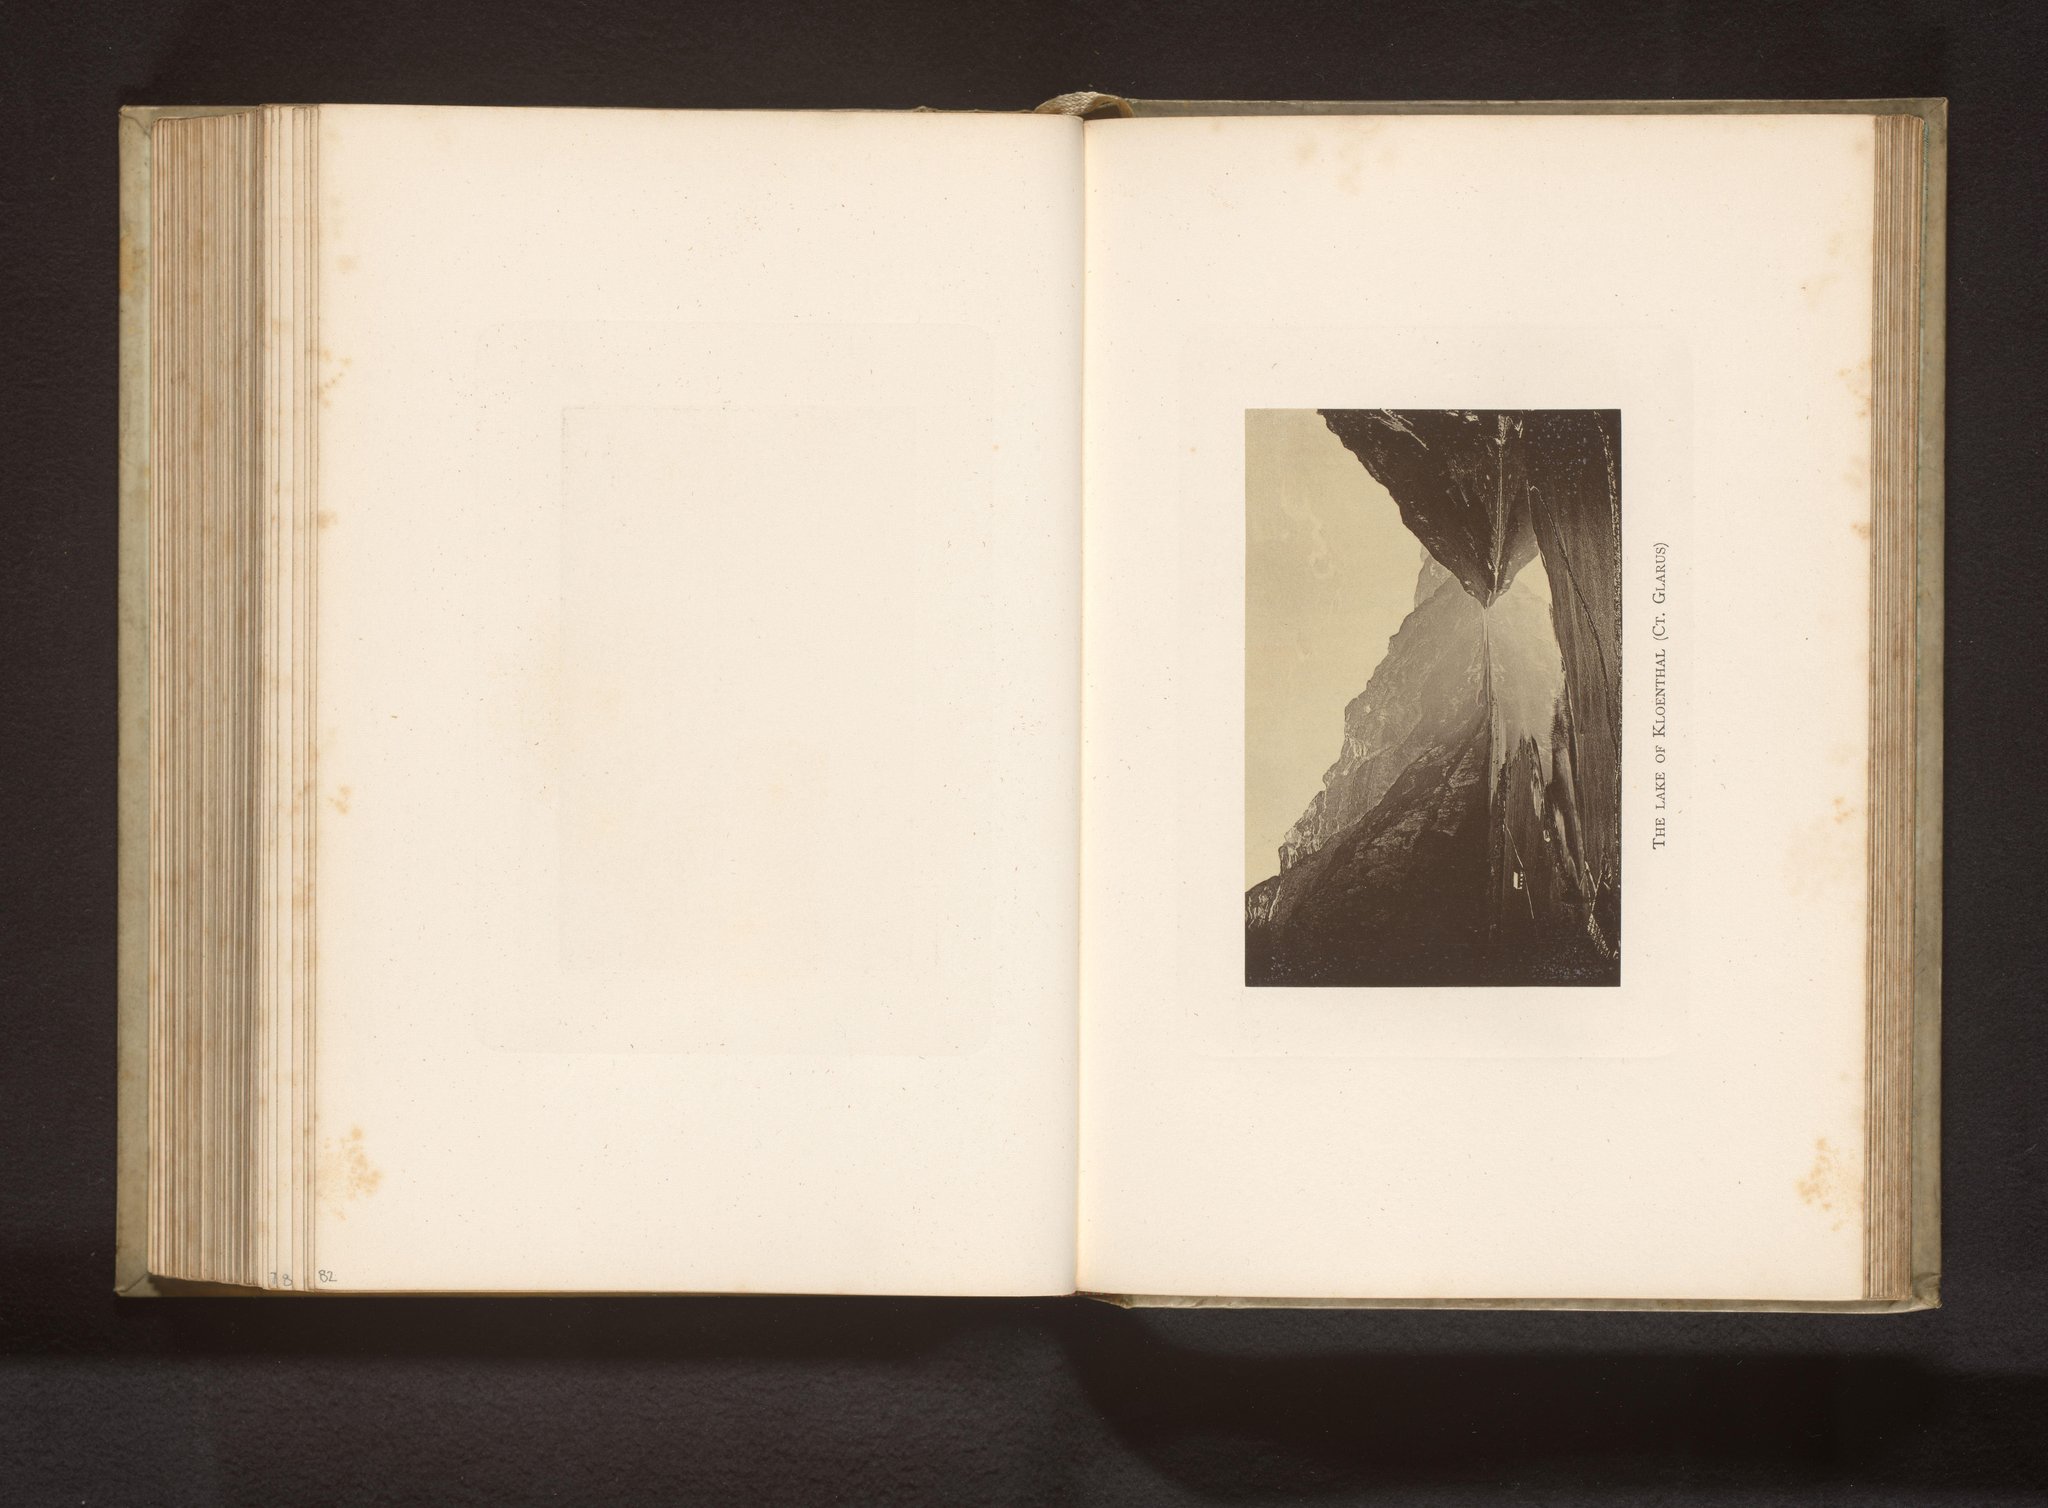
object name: page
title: The lake of Kloenthal (Ct. Glarus)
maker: Anonymous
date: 1874-1884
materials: paper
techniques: photograph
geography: glarus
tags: lake, mountains